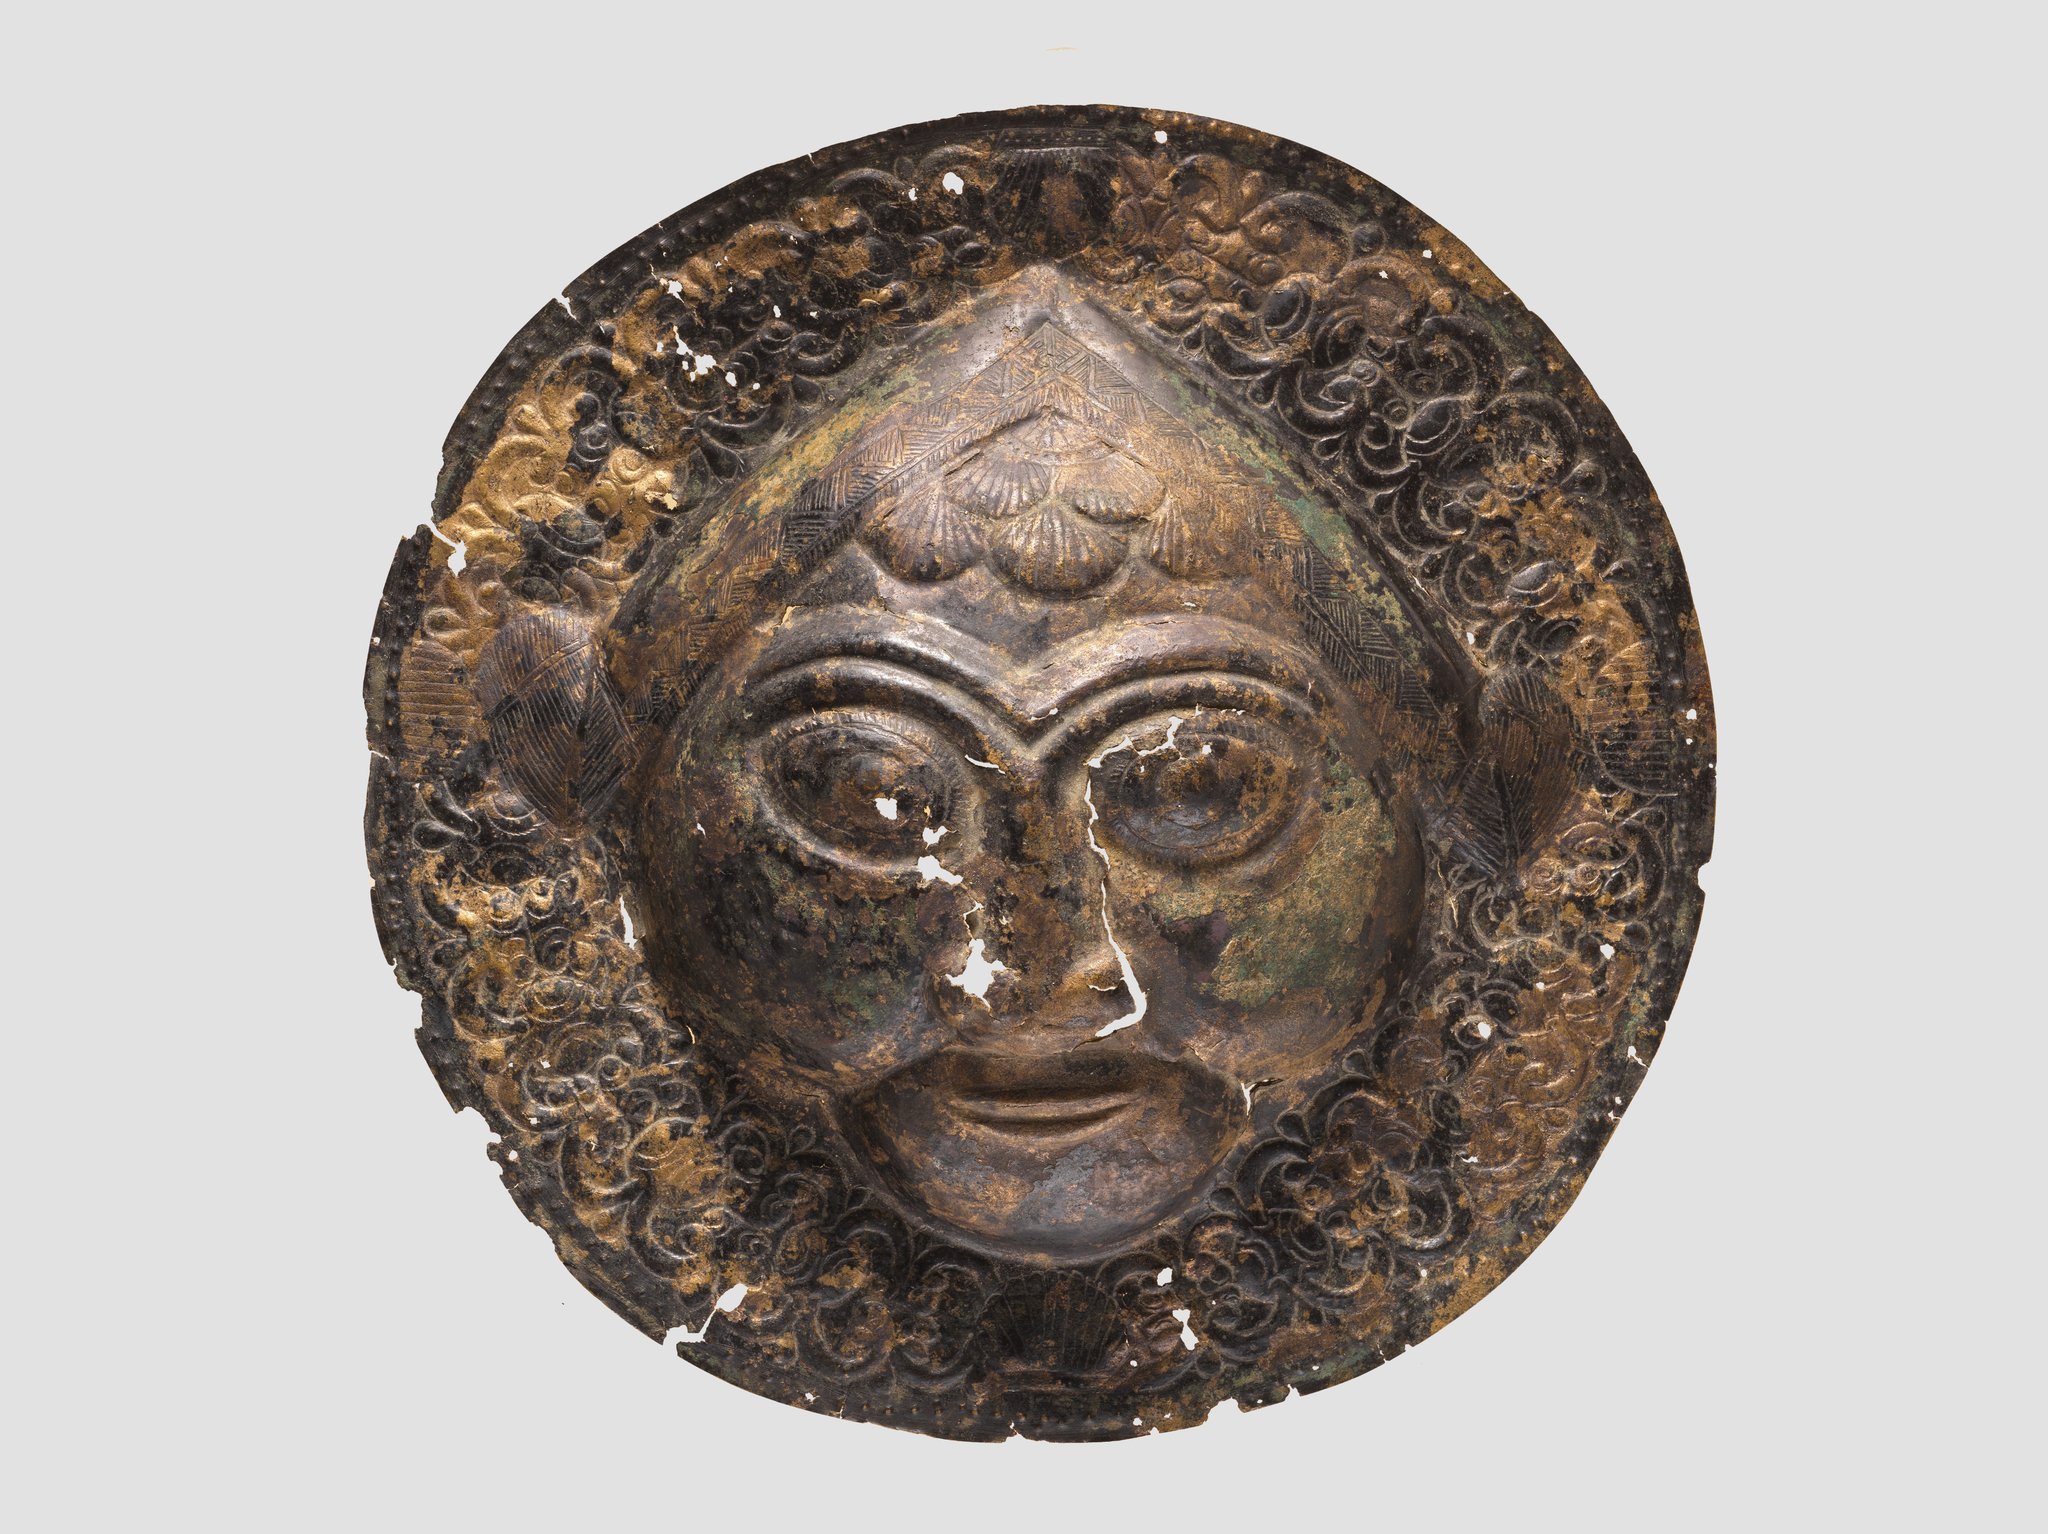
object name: disc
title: Disc plaque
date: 800-601 BCE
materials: bronze, gilt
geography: iran, probably from luristan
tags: masks